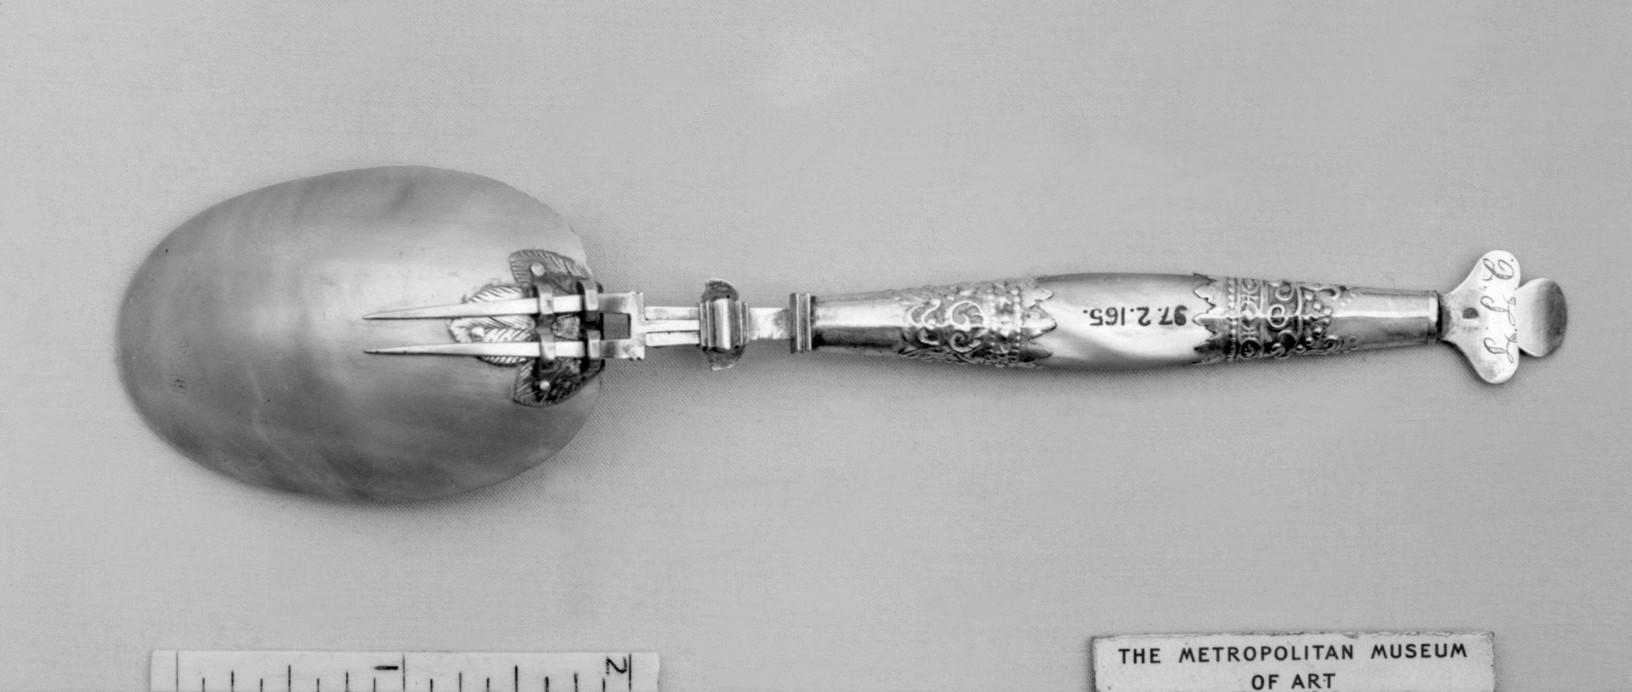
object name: spoon and fork combination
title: Folding spoon and fork combination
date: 1801-1833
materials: pearl, shell, silver